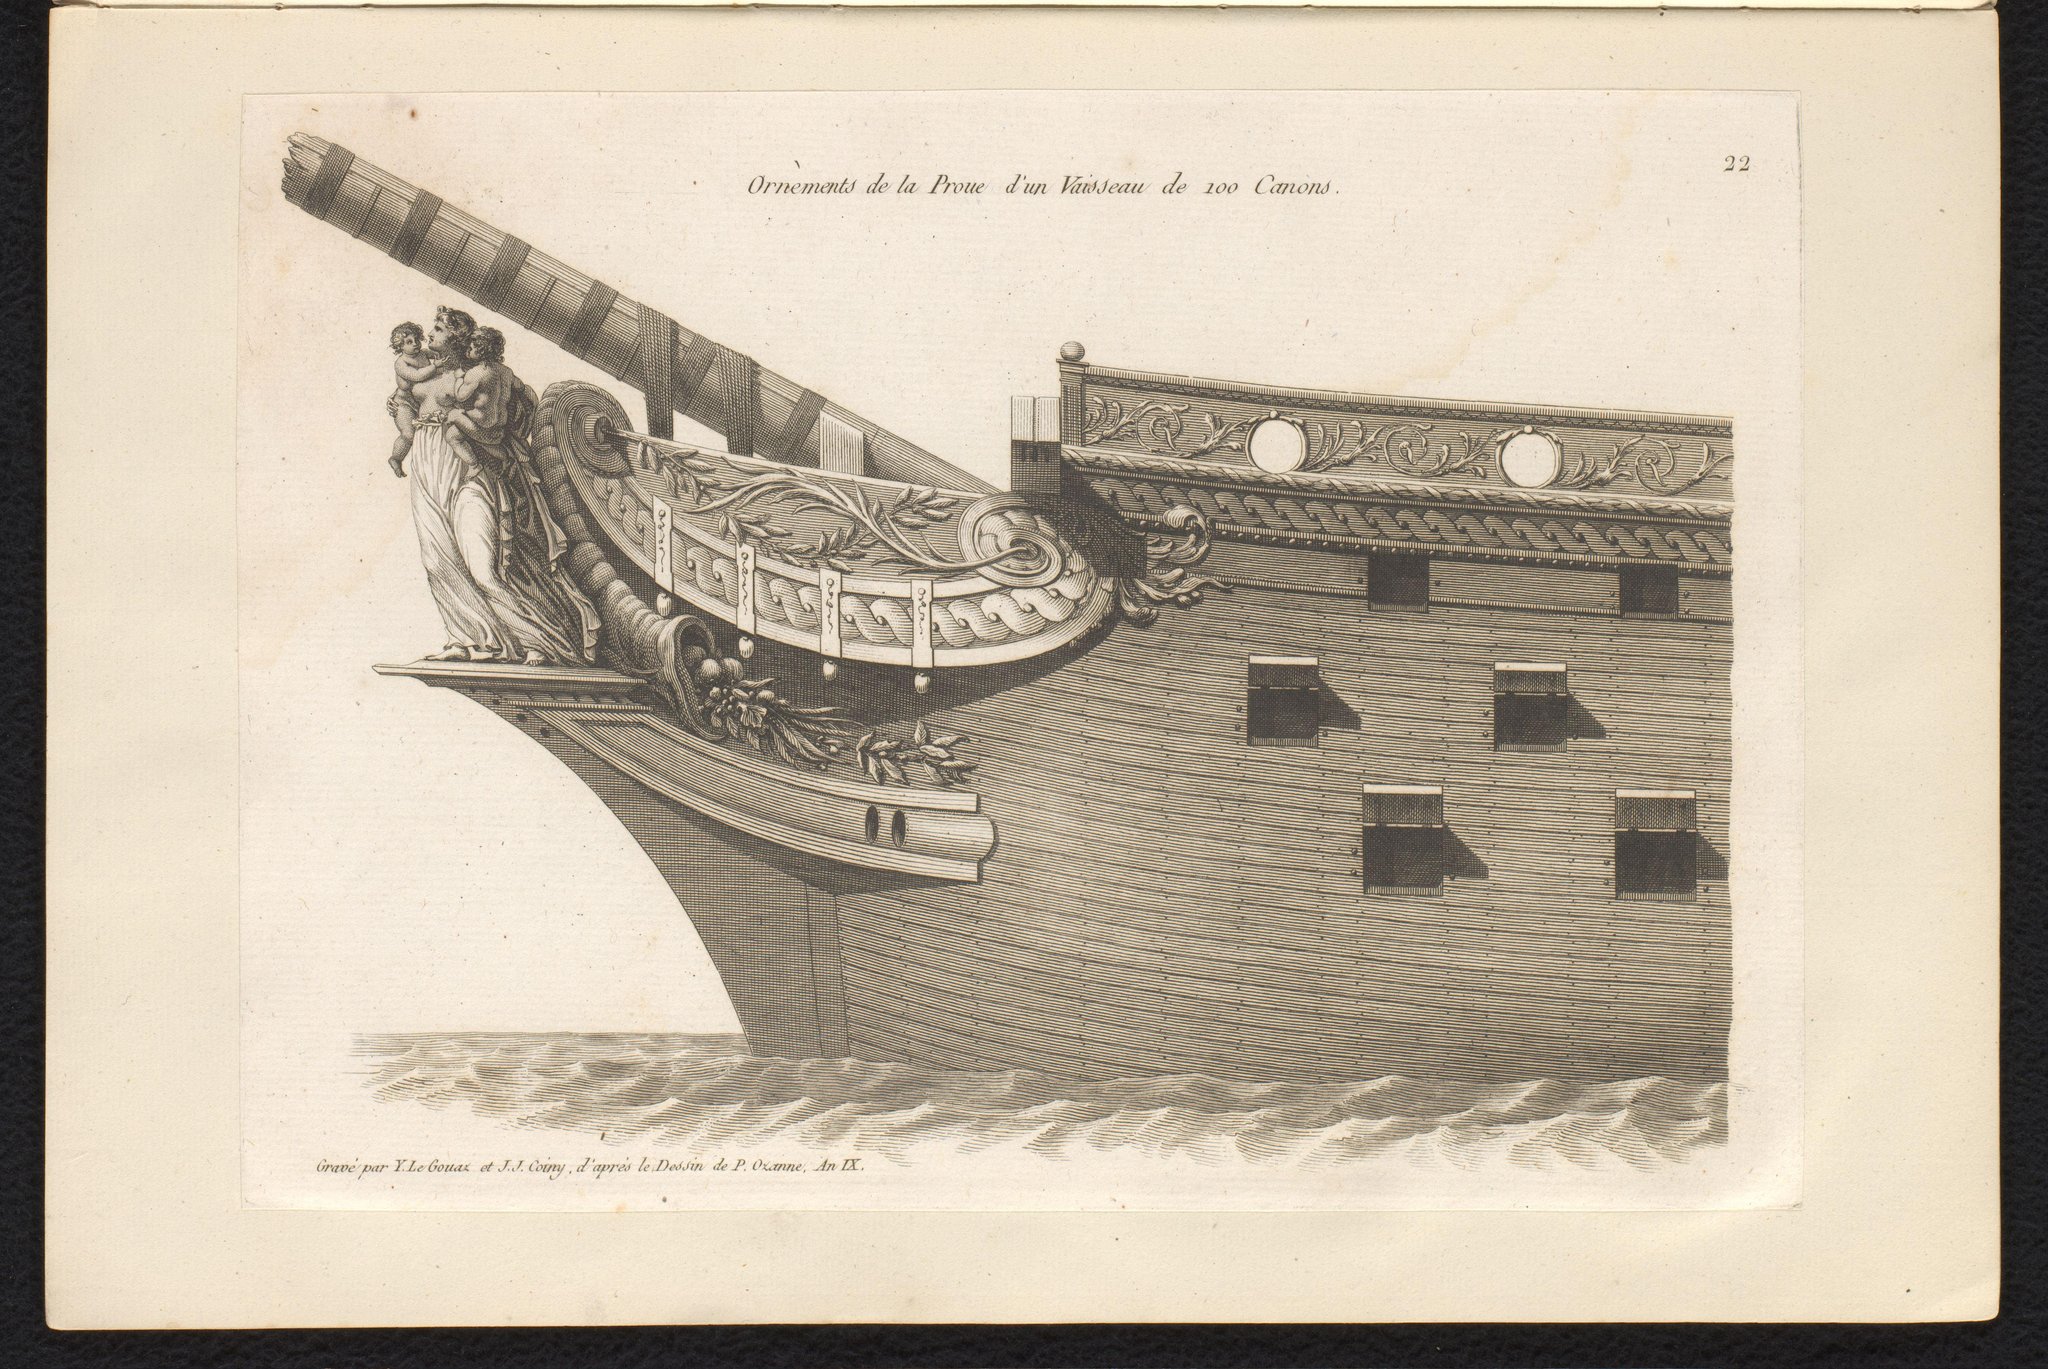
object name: ornament print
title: Boegornamenten van diverse vaartuigen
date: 1800-1801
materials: paper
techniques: engraving, etching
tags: charity, 'caritas'; 'carità' (ripa) ~ one of the three theological virtues, sailing-ship, sailing-boat, parts of ship's exterior: bow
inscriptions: collector's mark: Lugt 2760, collector's mark: Lugt 2228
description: Caritas met twee kinderen als boegbeeld; achter haar een hoorn des overvloeds. Deze prent maakt deel uit van een album.